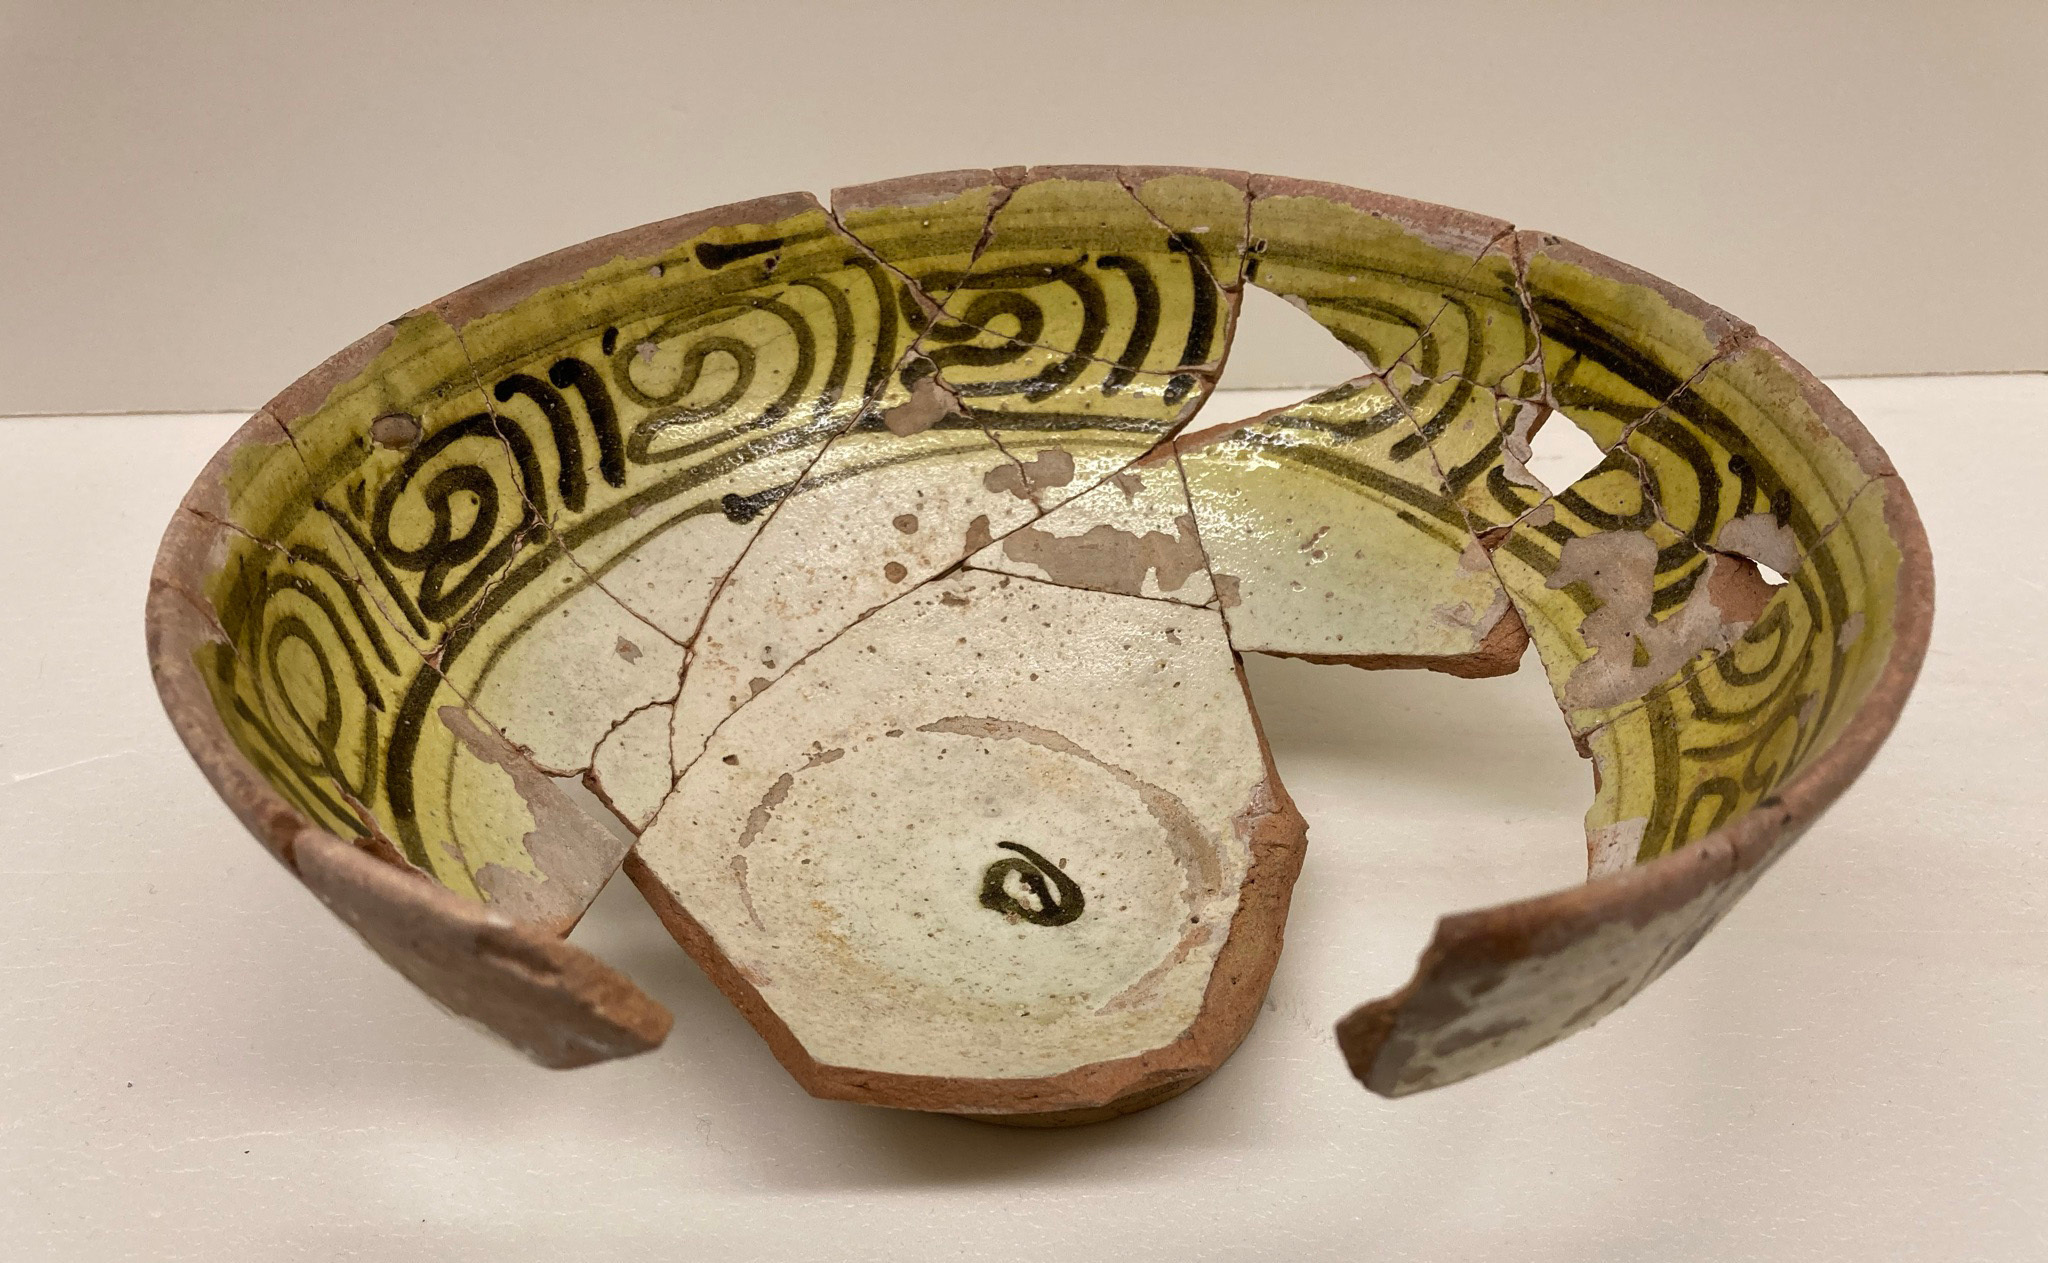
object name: bowl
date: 901-1000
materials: earthenware, glaze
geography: iran